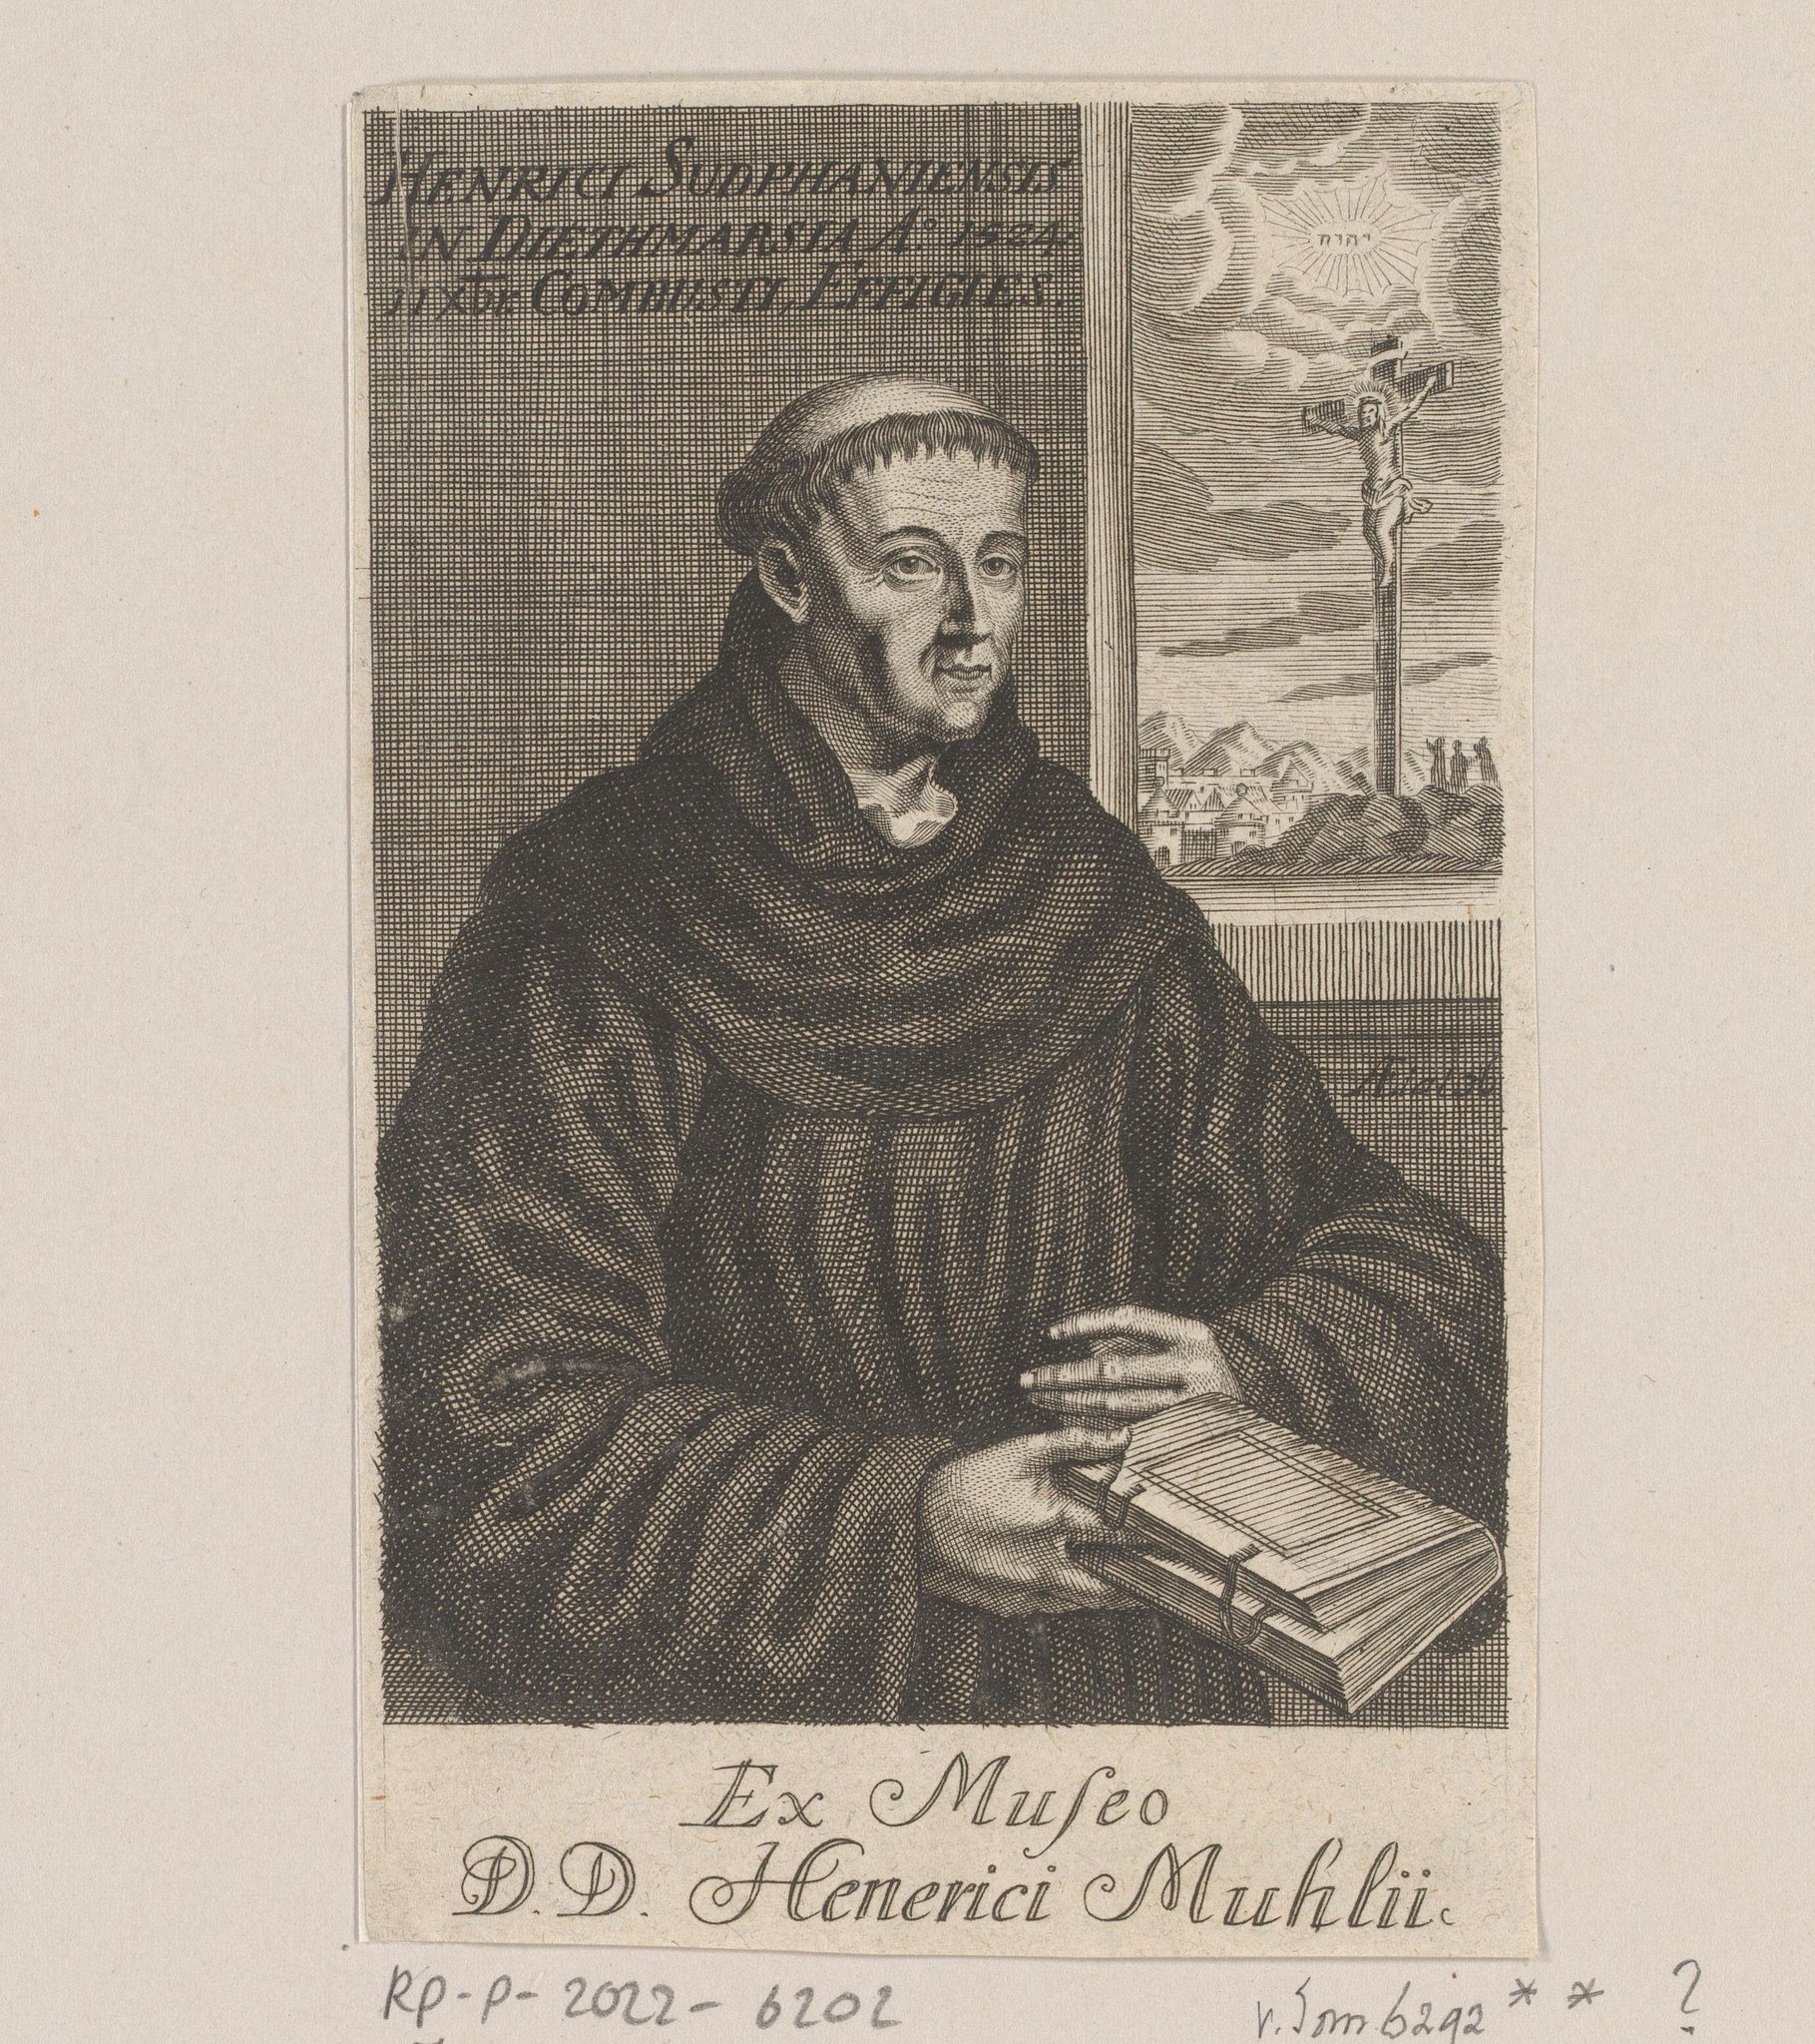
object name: print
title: Portret van Hendrik van Zutphen op 36-jarige leeftijd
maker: Anonymous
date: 1713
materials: paper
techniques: engraving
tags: historical persons, functionaries and dignitaries ~ protestant churches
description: Prent waarschijnlijk uit: Groß, Ludwig u. Unschuldige Nachrichten von alten und neuen theologischen Sachen, Büchern, Urkunden (...). Leipzig: Johann Friedrich Braun, 1713.